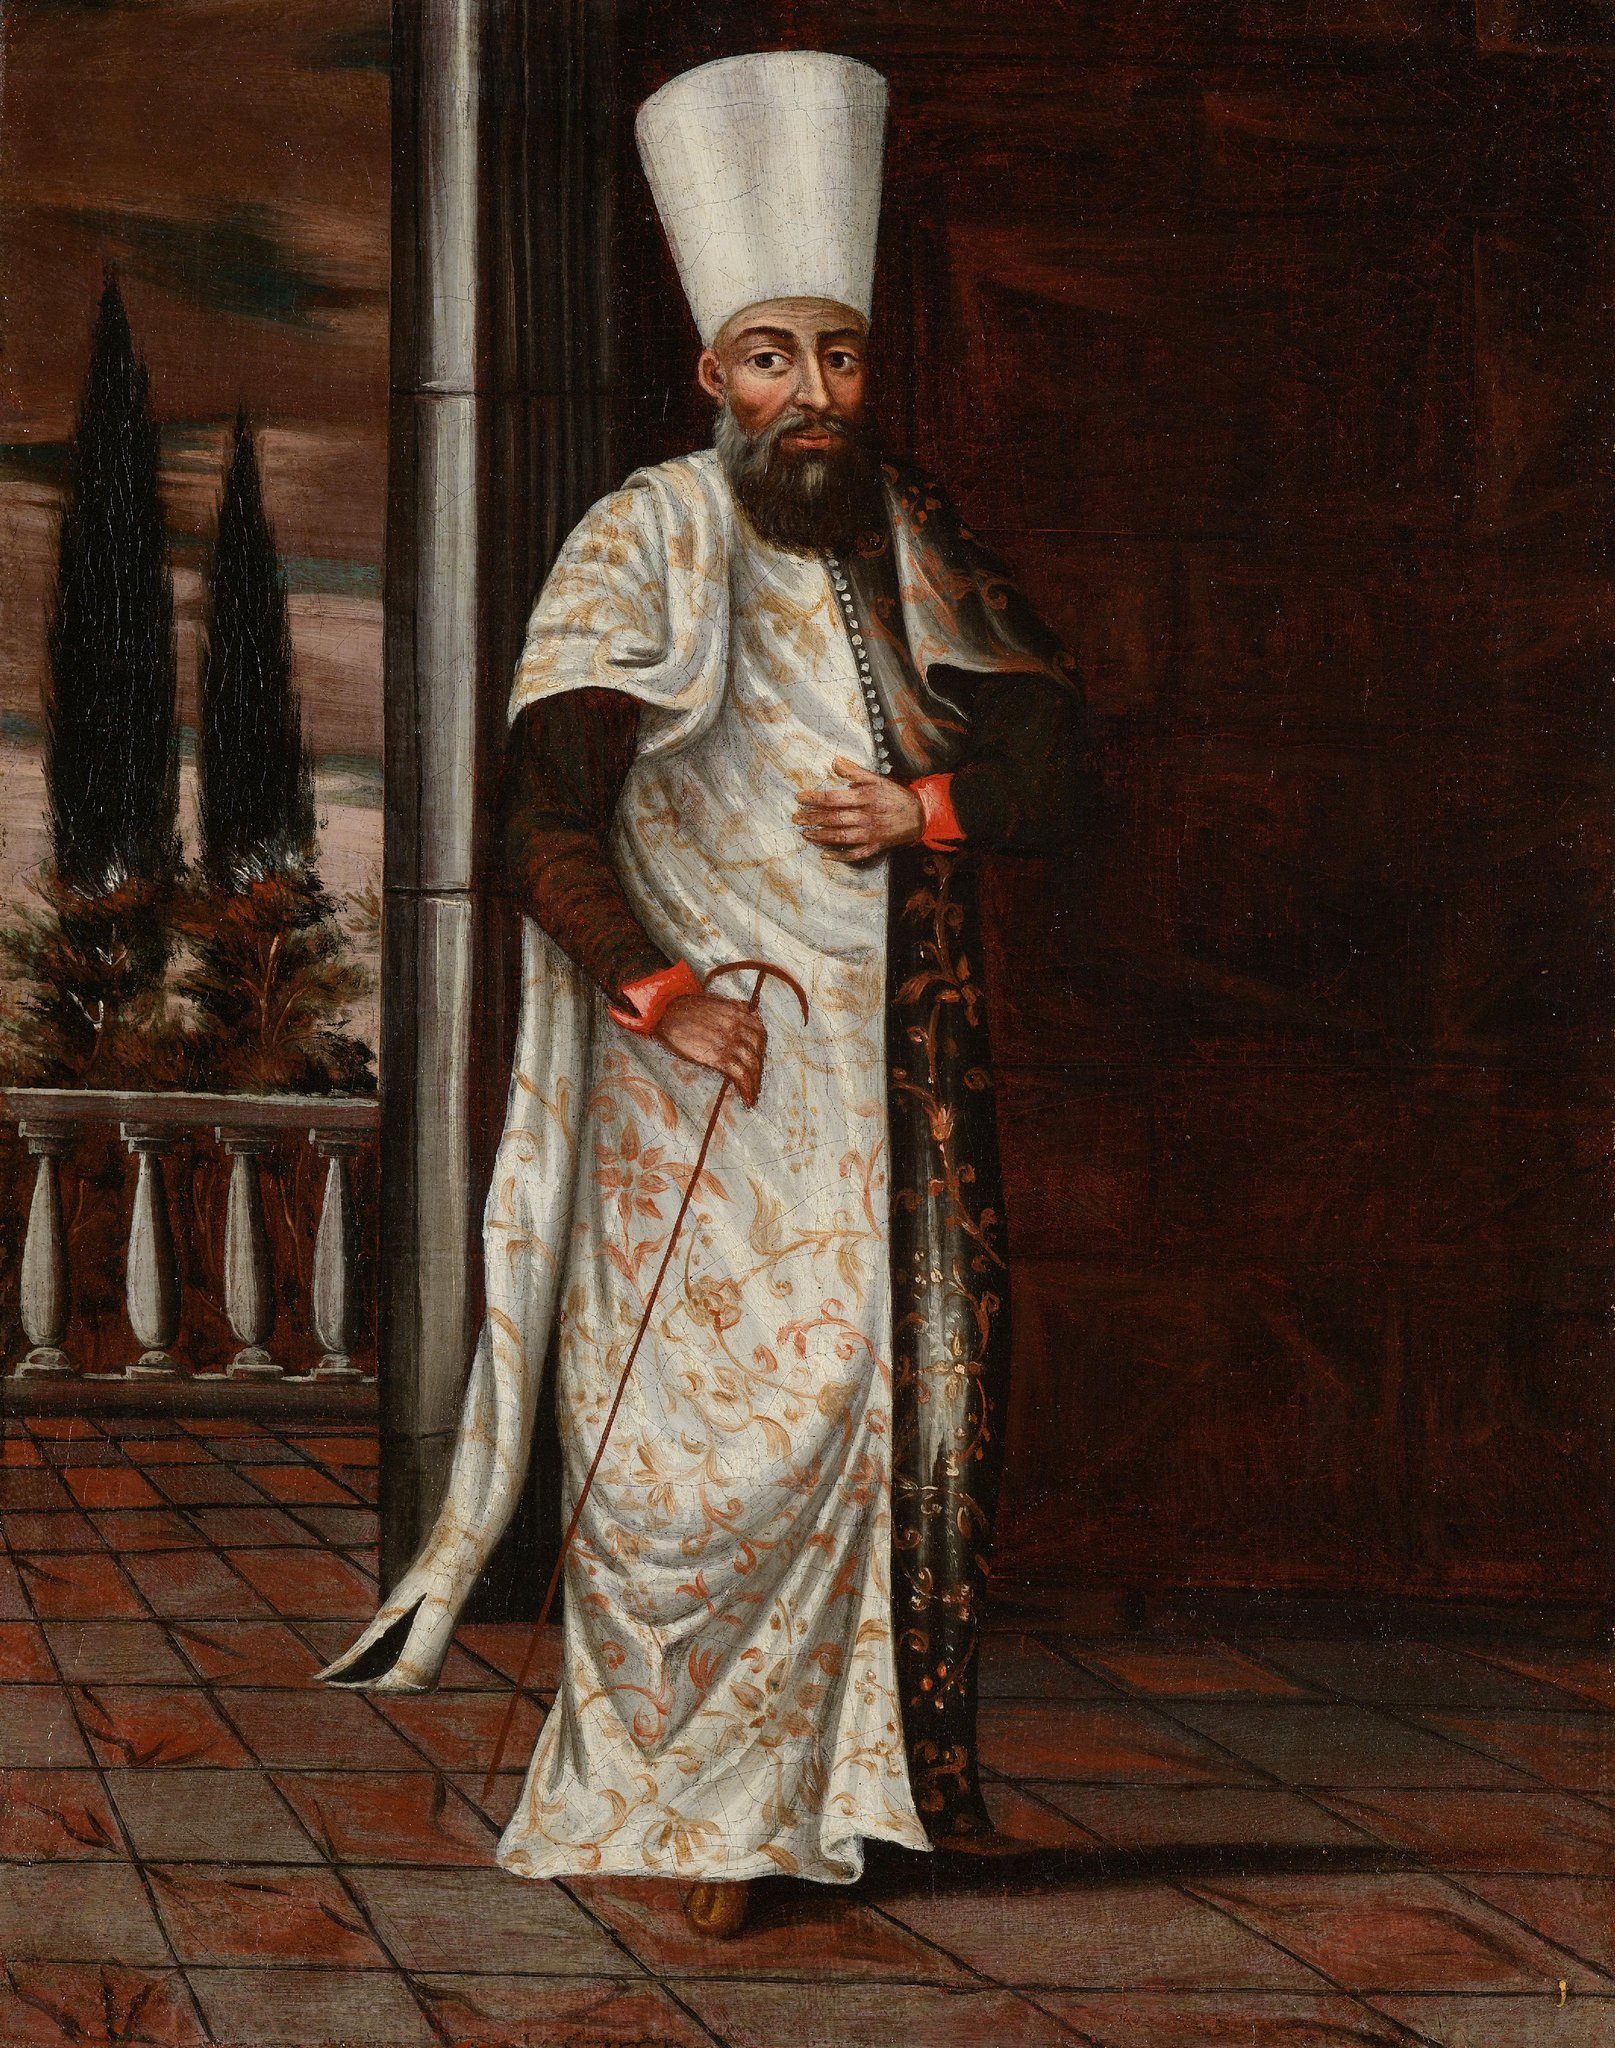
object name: painting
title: The Chaous Bachi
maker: jean baptiste vanmour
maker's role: painter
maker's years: 1671-1737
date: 1700-1737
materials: canvas, oil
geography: istanbul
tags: royal household; courtiers, retinue, train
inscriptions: number: ‘1’, inscription: ‘Chaous Bazzi off Oversten der Rijksbezendelingen’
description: De Tchavouch Bachi, opperheraut, commandant van de boodschappers van de sultan en luitenant van de grootvizier in zijn hoedanigheid van rechter, tevens overste van het detachement dat de buitenlandse gezanten op hun tocht naar de audiëntie van de sultan vergezelt. Staande, ten voeten uit, op de achtergrond een balustrade en tuin.